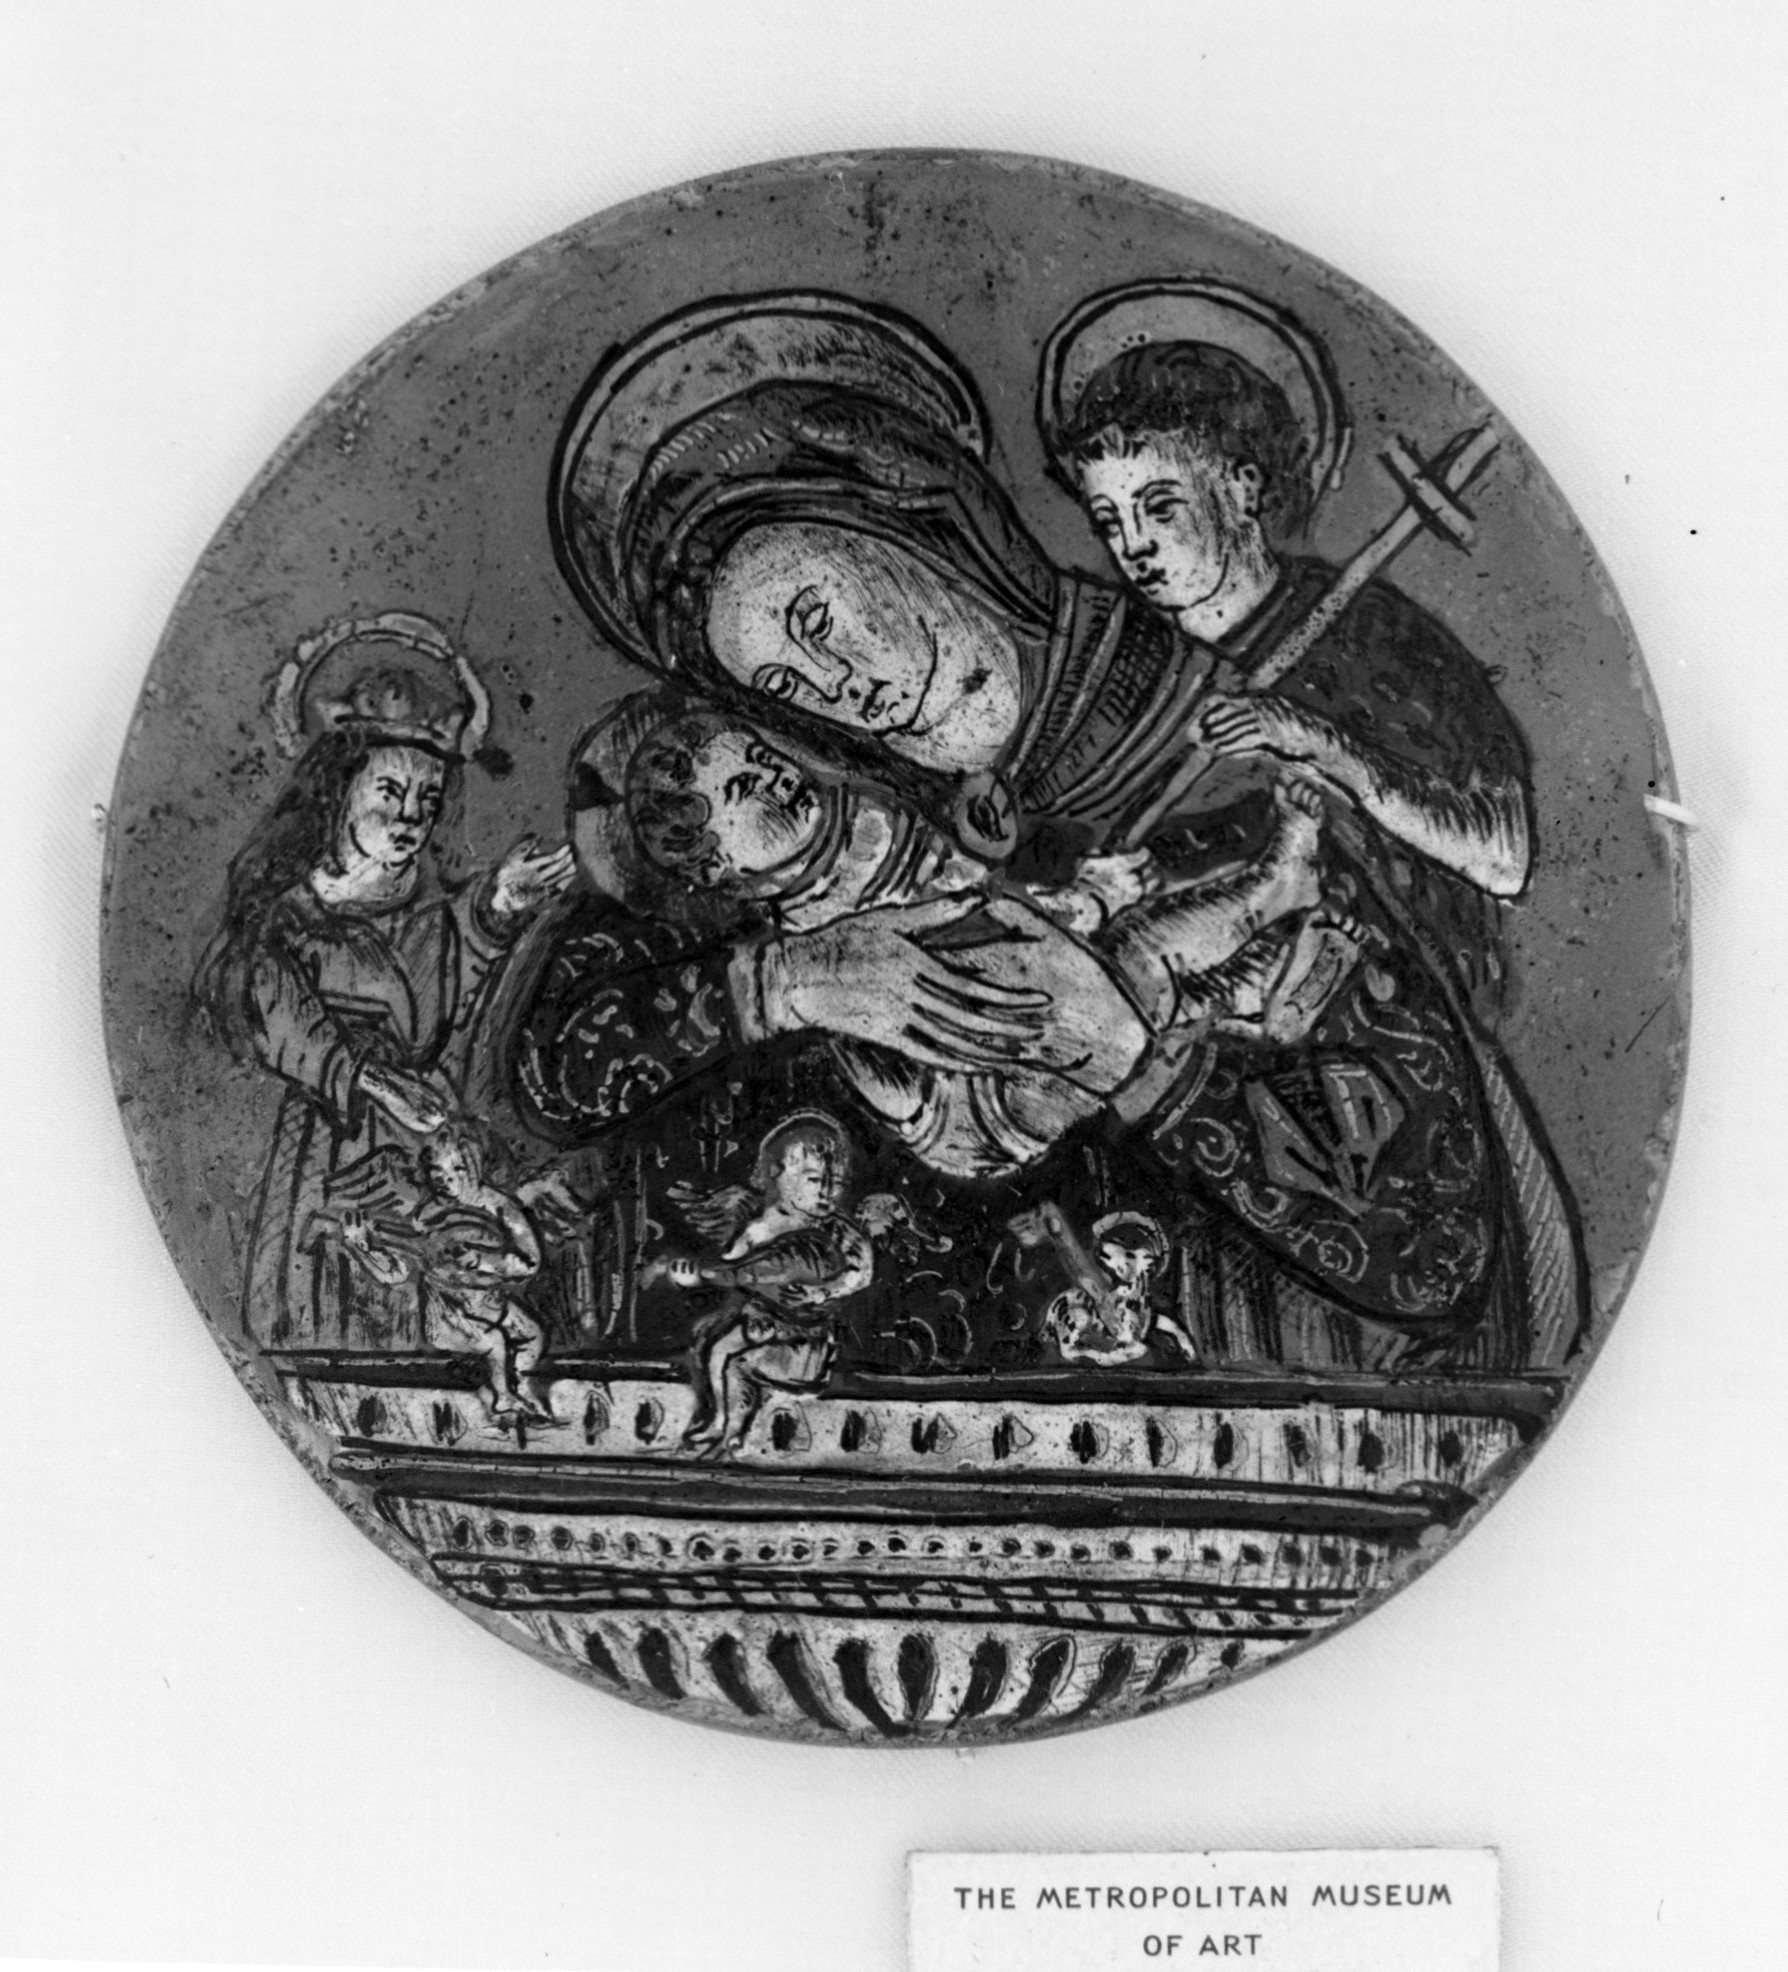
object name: plaque fragment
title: Madonna and Child between Saint John and a sainted abbess (probably Saint Catherine of Alexandria)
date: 1501-1600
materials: glass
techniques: enamel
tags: angels,madonna and child,saint catherine,saint john the baptist,cross